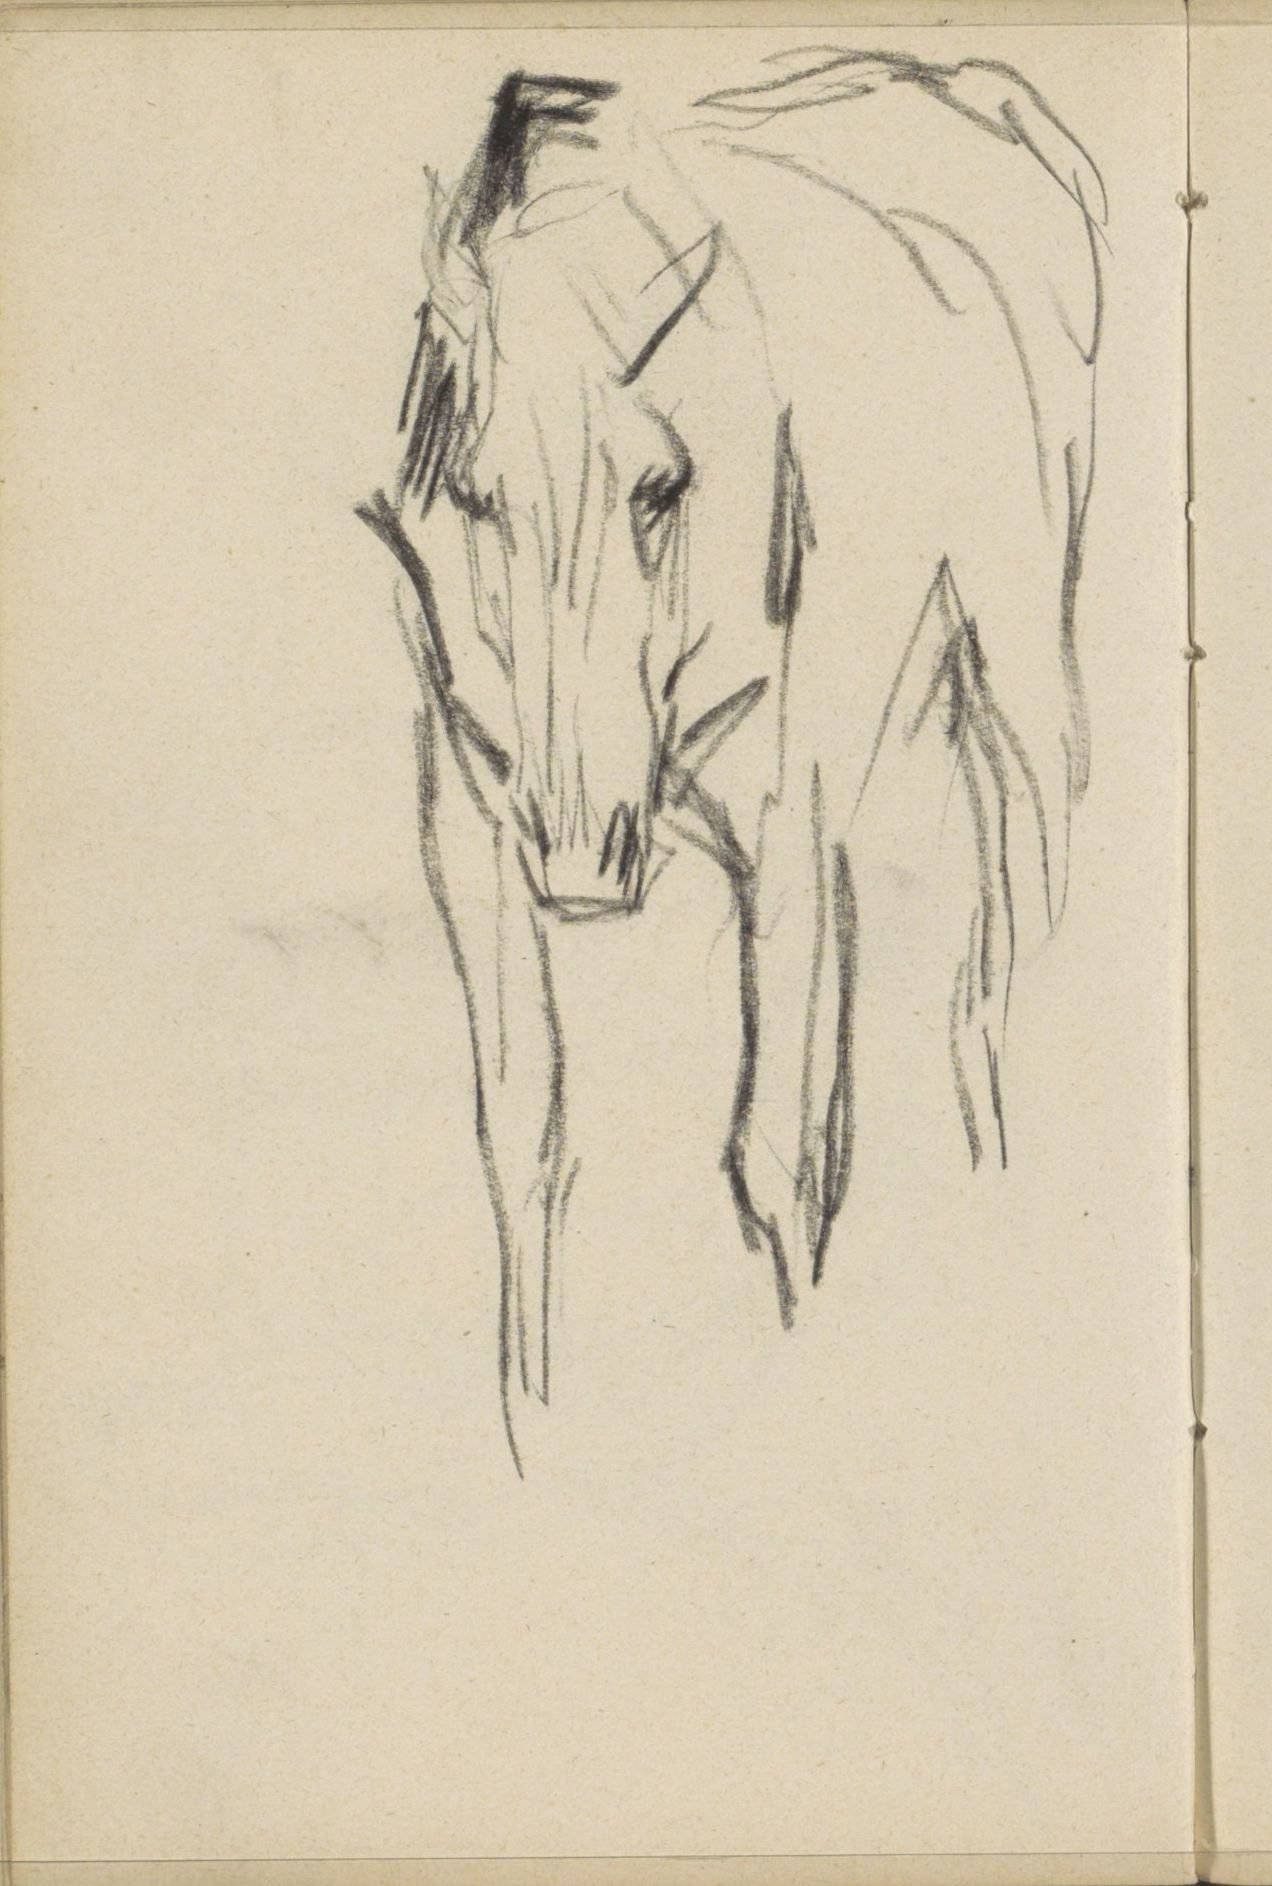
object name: sketchbook leaf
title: Paard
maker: george hendrik breitner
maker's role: draughtsman, painter, print maker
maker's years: 1857-1923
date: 1902-1914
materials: chalk, paper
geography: amsterdam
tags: horse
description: Paard. Pagina 51 uit een schetsboek met 46 bladen vervaardigd te Noord-Holland en Utrecht.